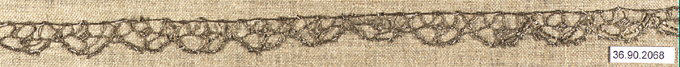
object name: piece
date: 1701-1800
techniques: lace